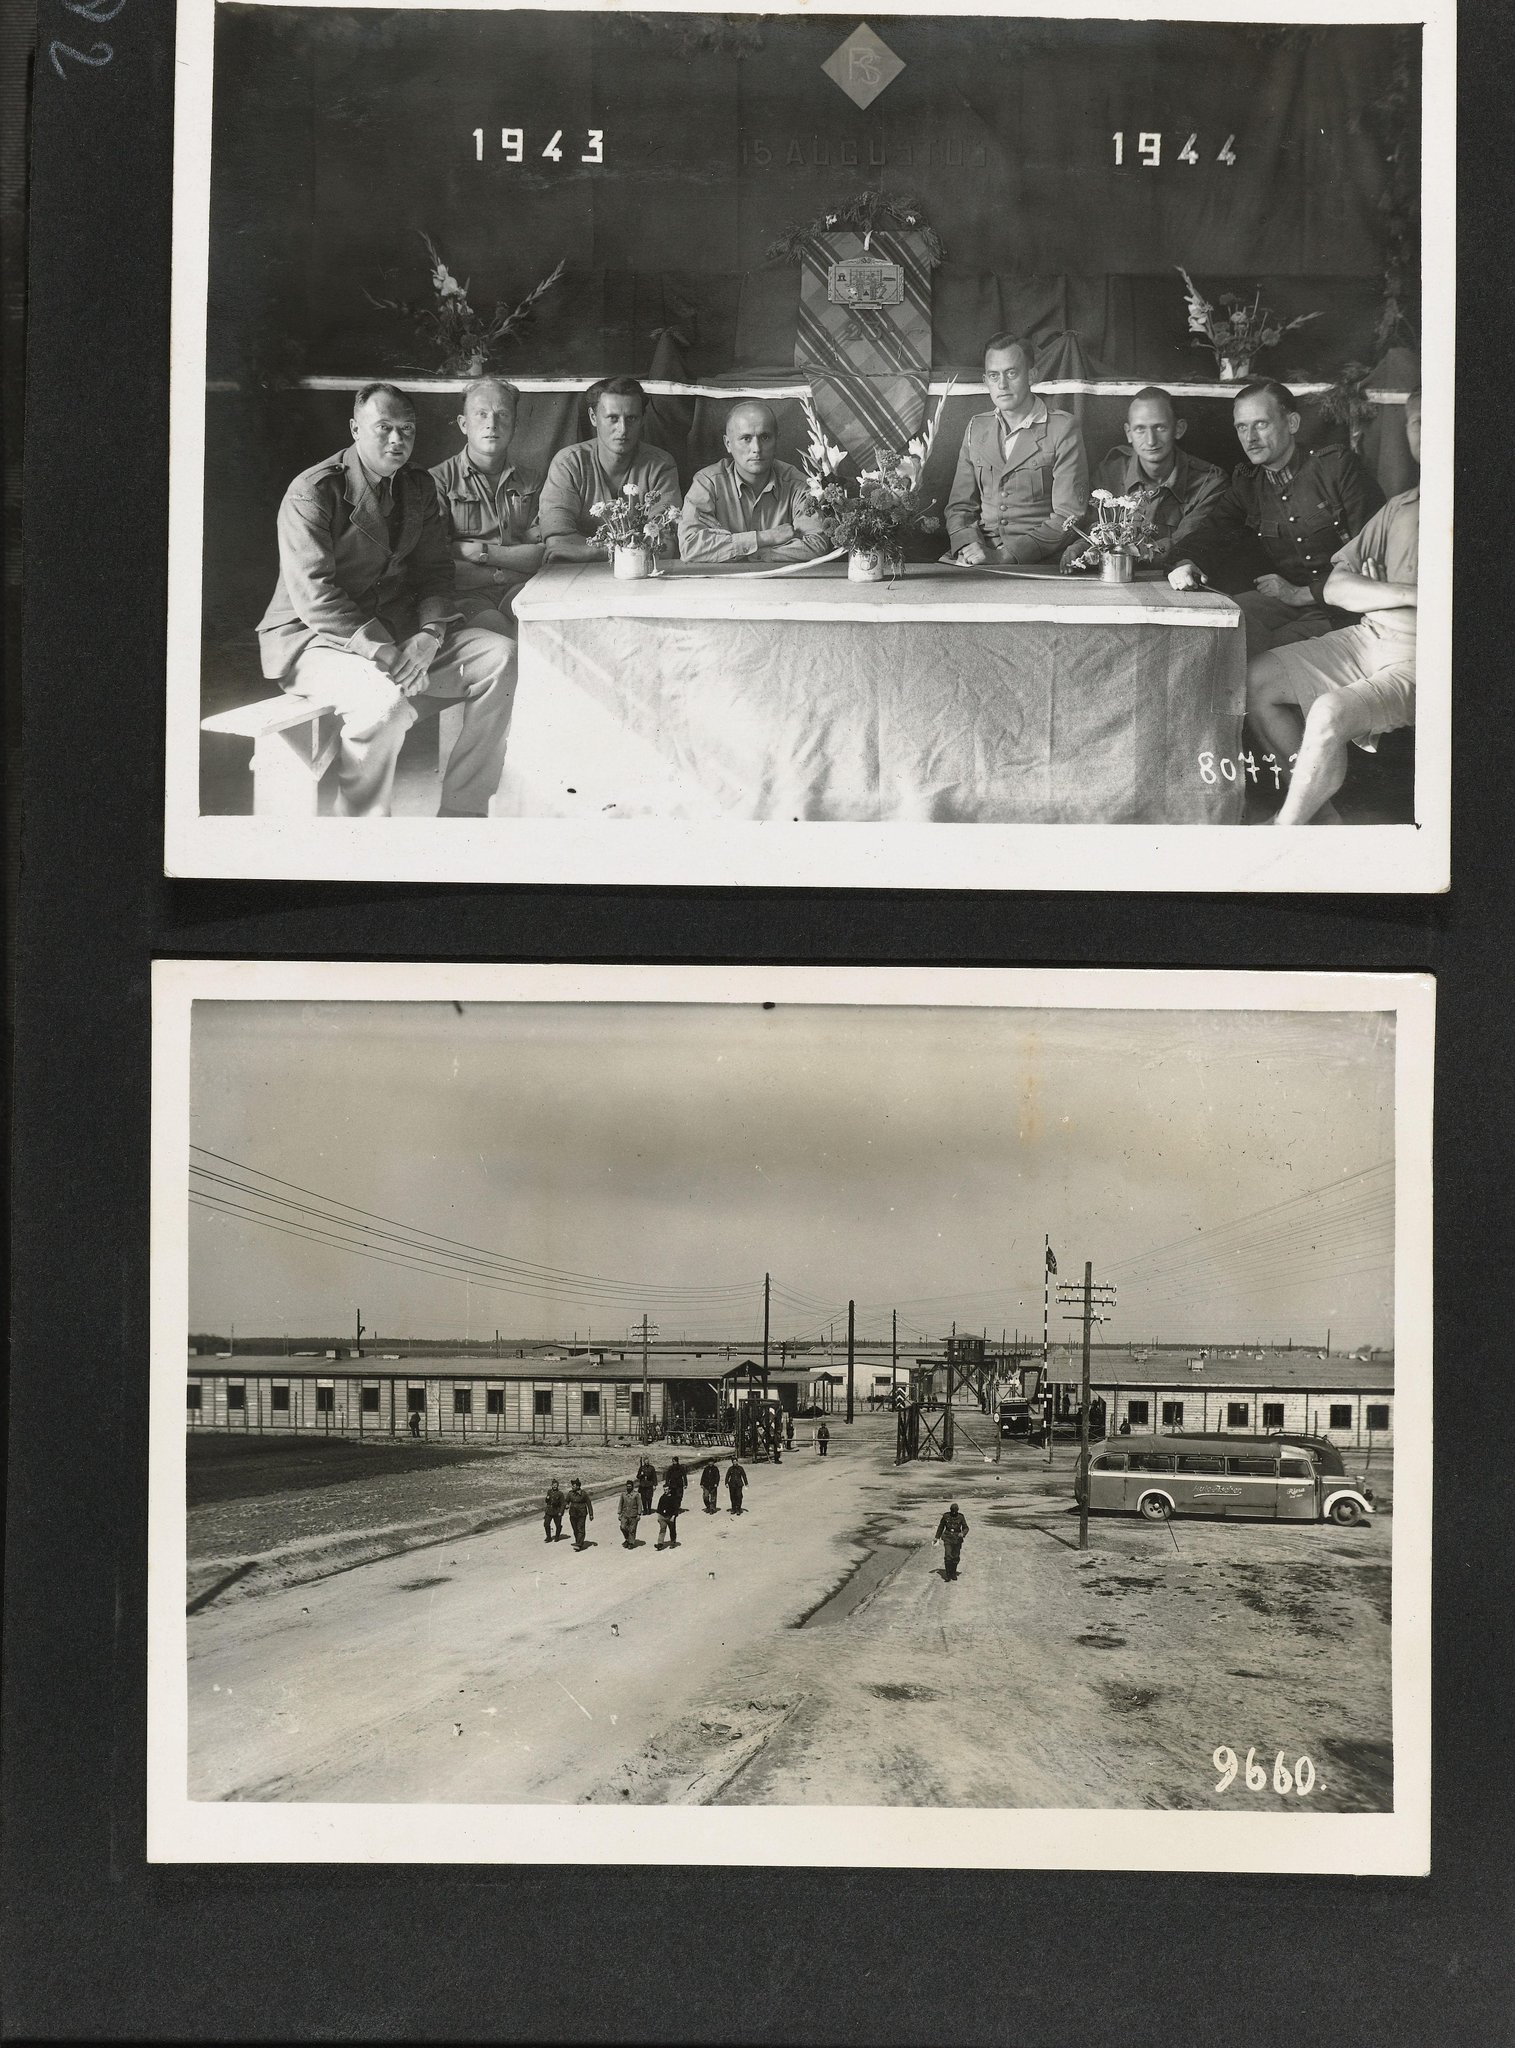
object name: photograph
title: Officieren en straat in kamp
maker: dick w.b. van maarseveen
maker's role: fotograaf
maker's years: 1905-1990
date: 1943-1945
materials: cardboard, photographic support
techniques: gelatin silver print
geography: muhlberg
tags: the hague, dick w.b. van maarseveen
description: Albumblad met twee foto's: een herdenkingsbijeenkomst van officieren, mogelijk augustus 1944, en de straat in het kamp. Onderdeel van een fotoalbum met foto's door Dick van Maarseveen van het krijgsgevangenenkamp Stalag IV B in Mühlberg in de periode 1943-1945.